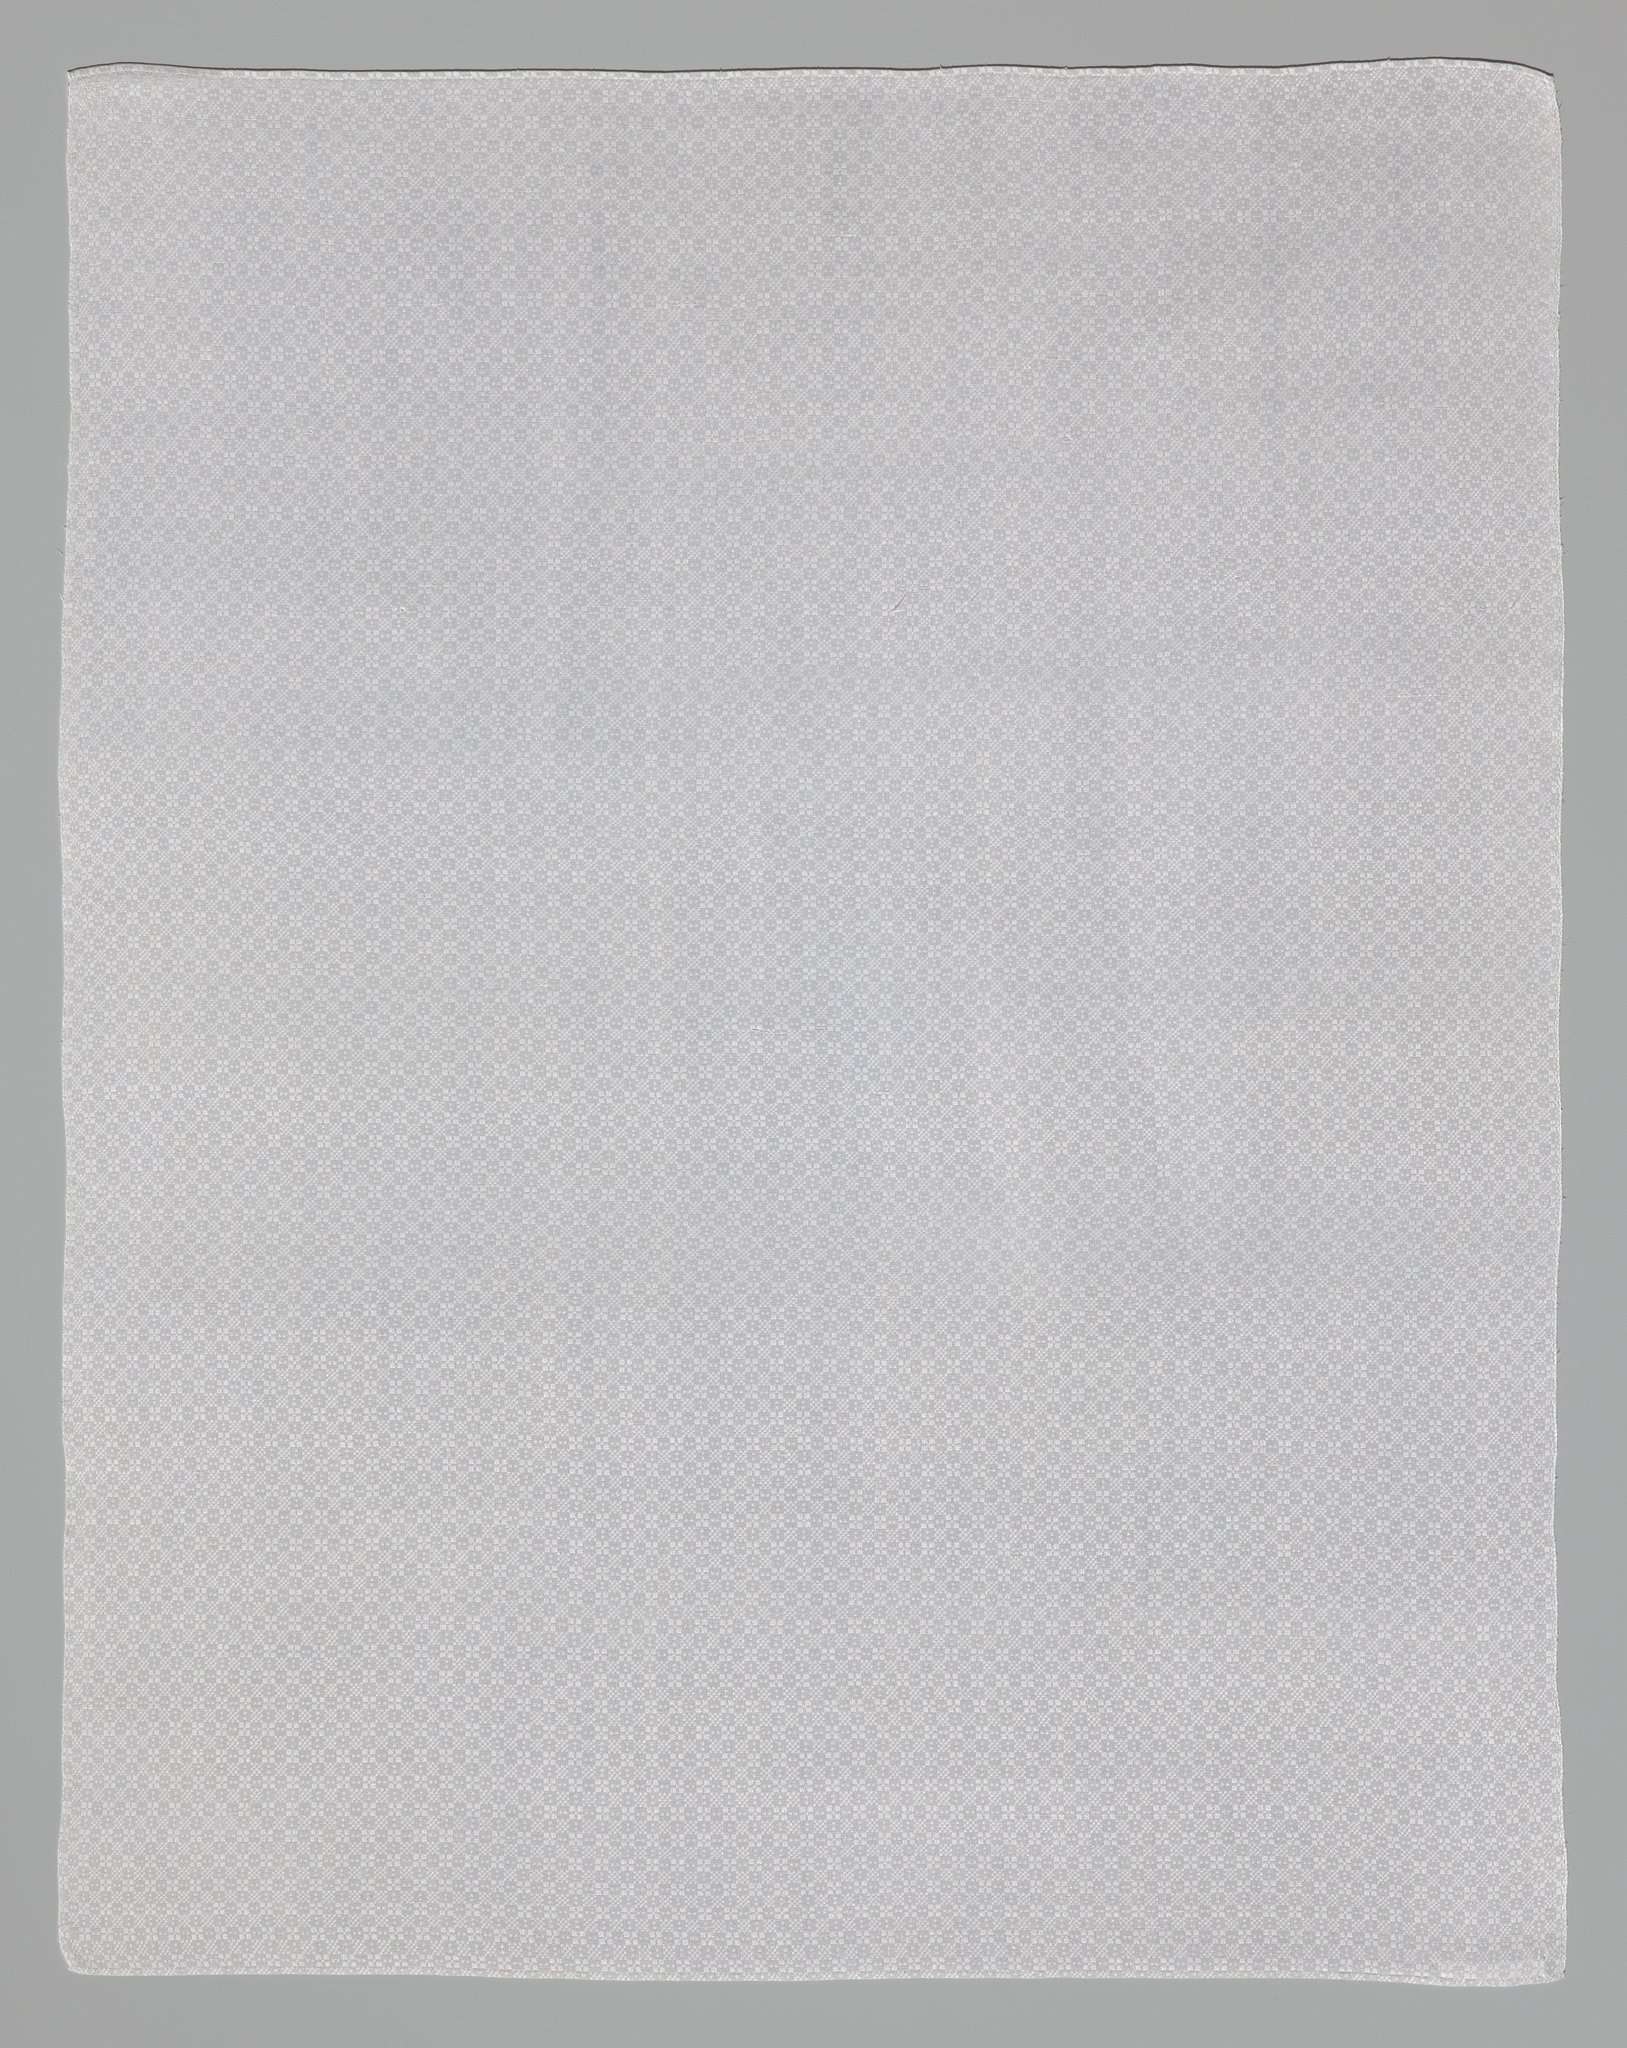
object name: napkin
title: Servet van linnen met pellenpatroon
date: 1627-1666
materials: linen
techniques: peeled fabric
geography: northern netherlands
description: wit linnen servet met pellen patroon, merk kroon IVG